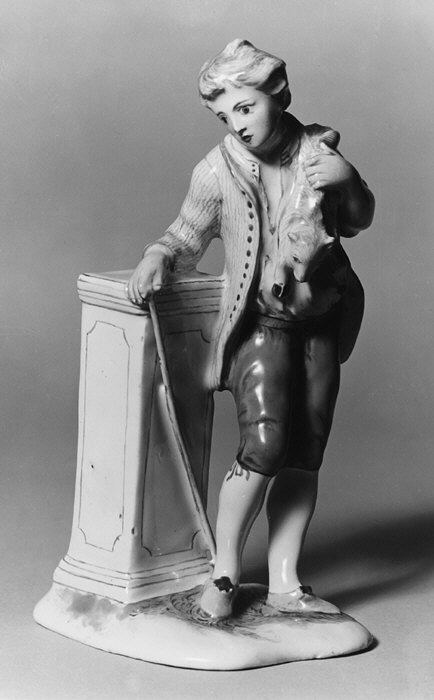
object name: figure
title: Boy (one of a pair)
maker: niderviller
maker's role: maker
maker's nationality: french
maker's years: 1735-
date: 1760-1770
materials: faience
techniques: glazing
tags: boys,dogs